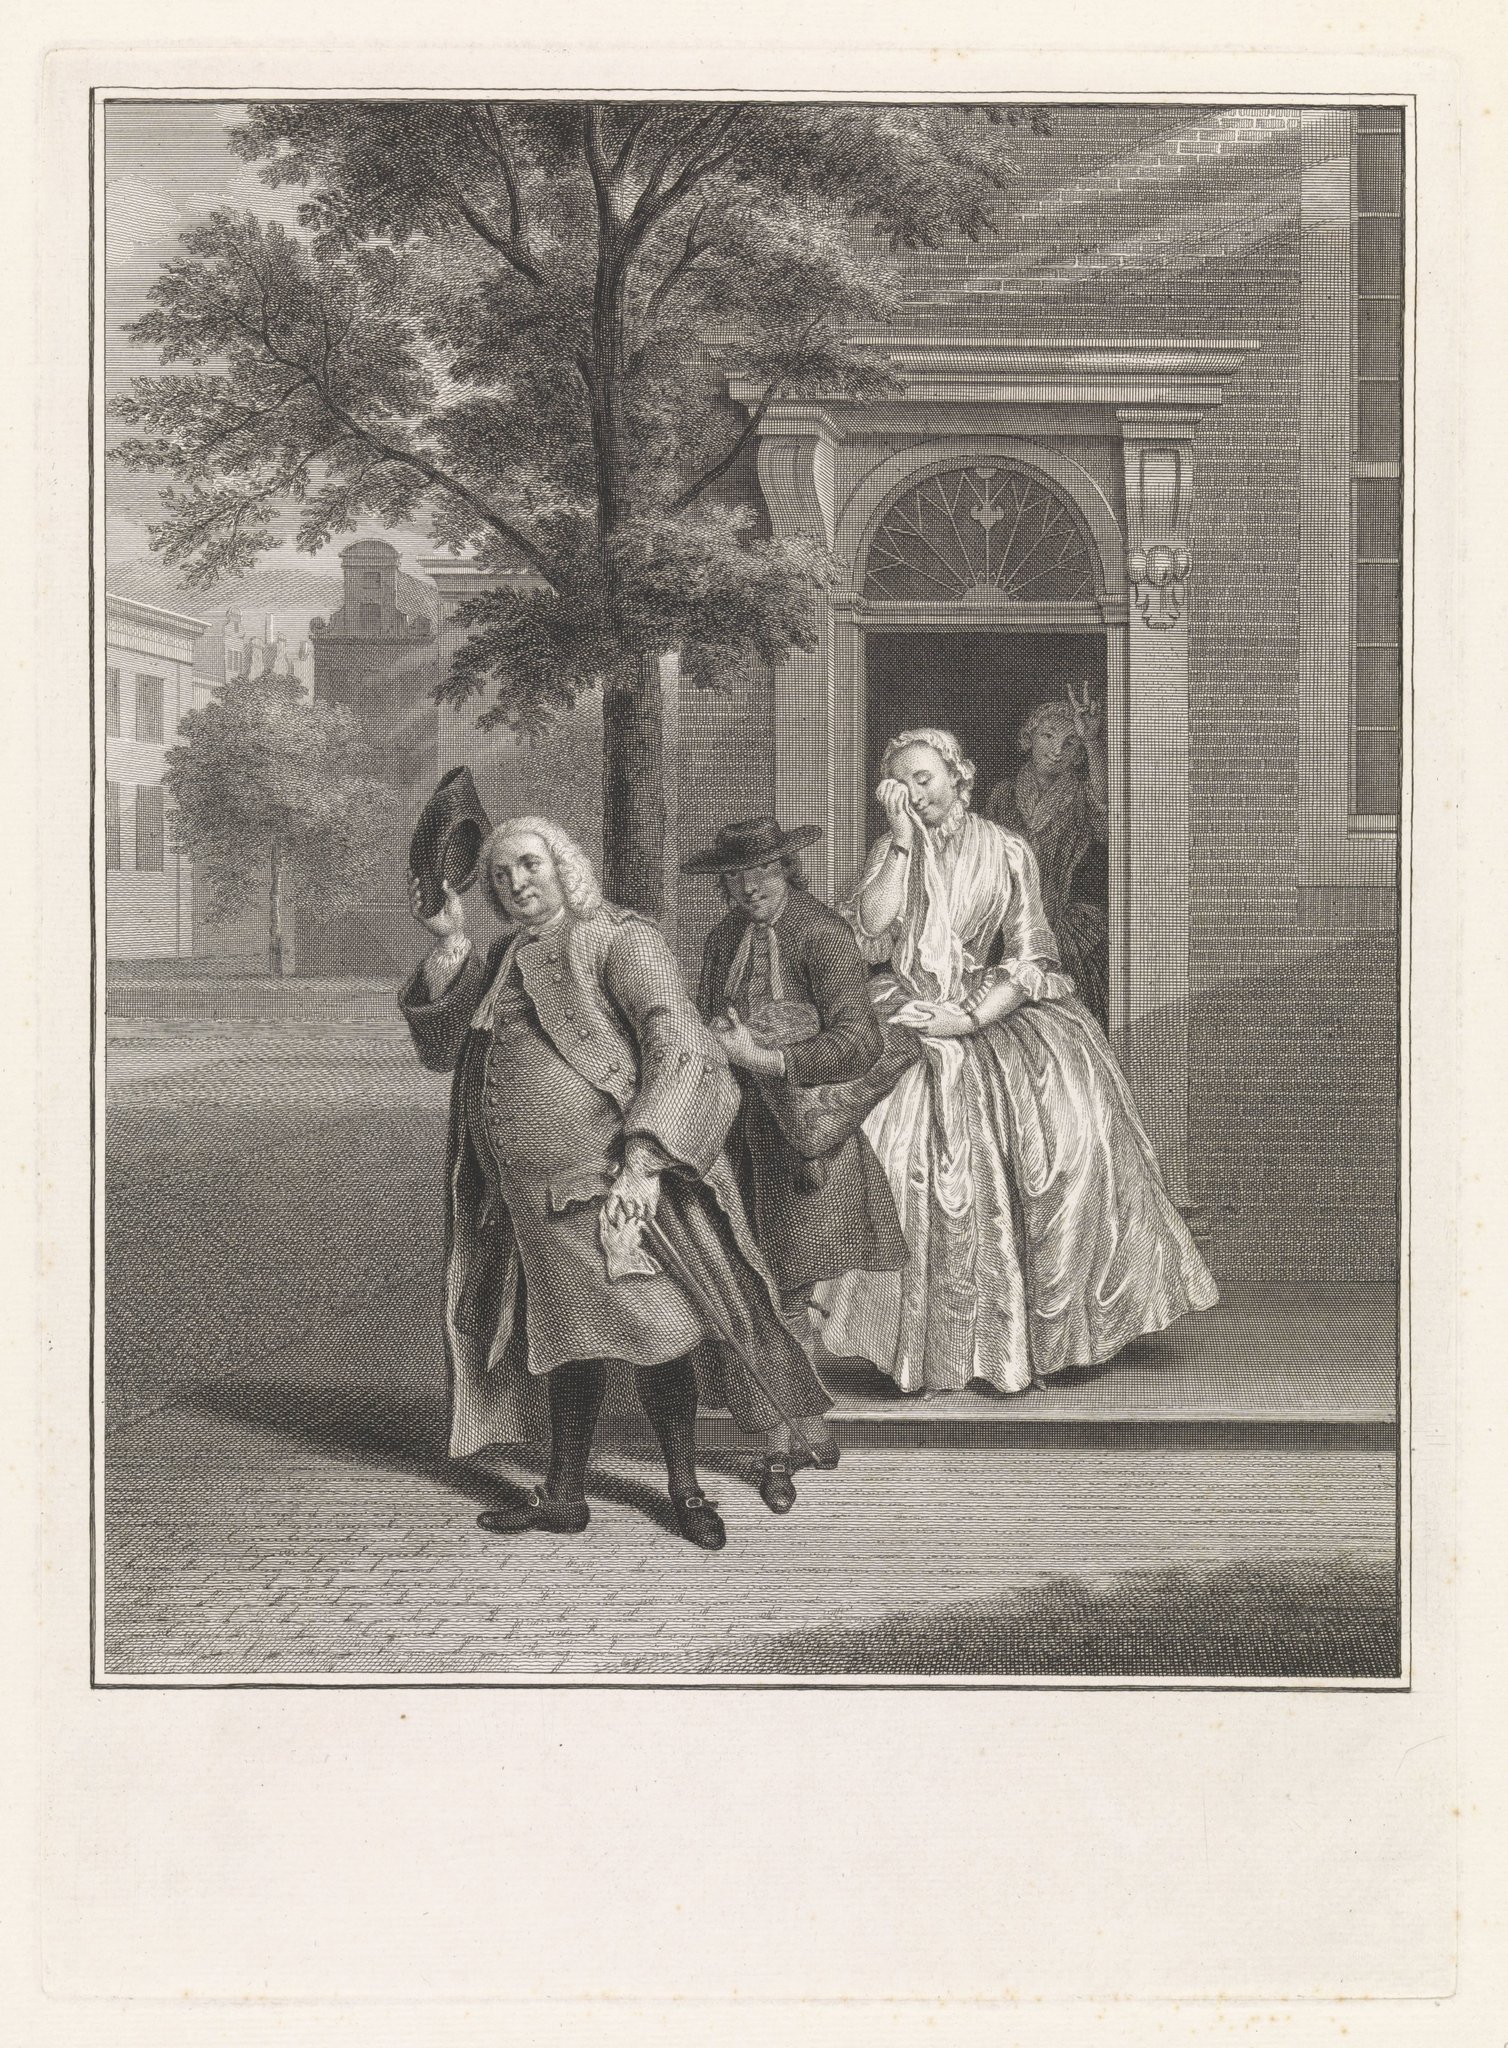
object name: print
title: De Ontdekte Schijndeugd: de geveinsde droefheid van Geertruy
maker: pieter tanjé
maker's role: draughtsman, print maker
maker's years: 1706-1761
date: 1757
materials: paper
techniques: engraving, etching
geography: amsterdam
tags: weeping, comedy, postures and gestures of index finger and middle finger, waving farewell ~ departure on a journey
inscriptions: collector's mark: Lugt 240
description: Geertruy veinst verdriet als ze haar man Filibert, die op zakenreis gaat, gedag zegt. Filibert heeft zojuist van zijn knecht Joris, die achter hem loopt, vernomen dat Geertruy hem met zijn neef bedriegt. De dienstmeid Bely bespot Filibert als bedrogen echtgenoot door twee vingers als horentjes bij haar hoofd te houden. Scène uit het toneelstuk De Ontdekte Schijndeugd, van David Lingelbach.